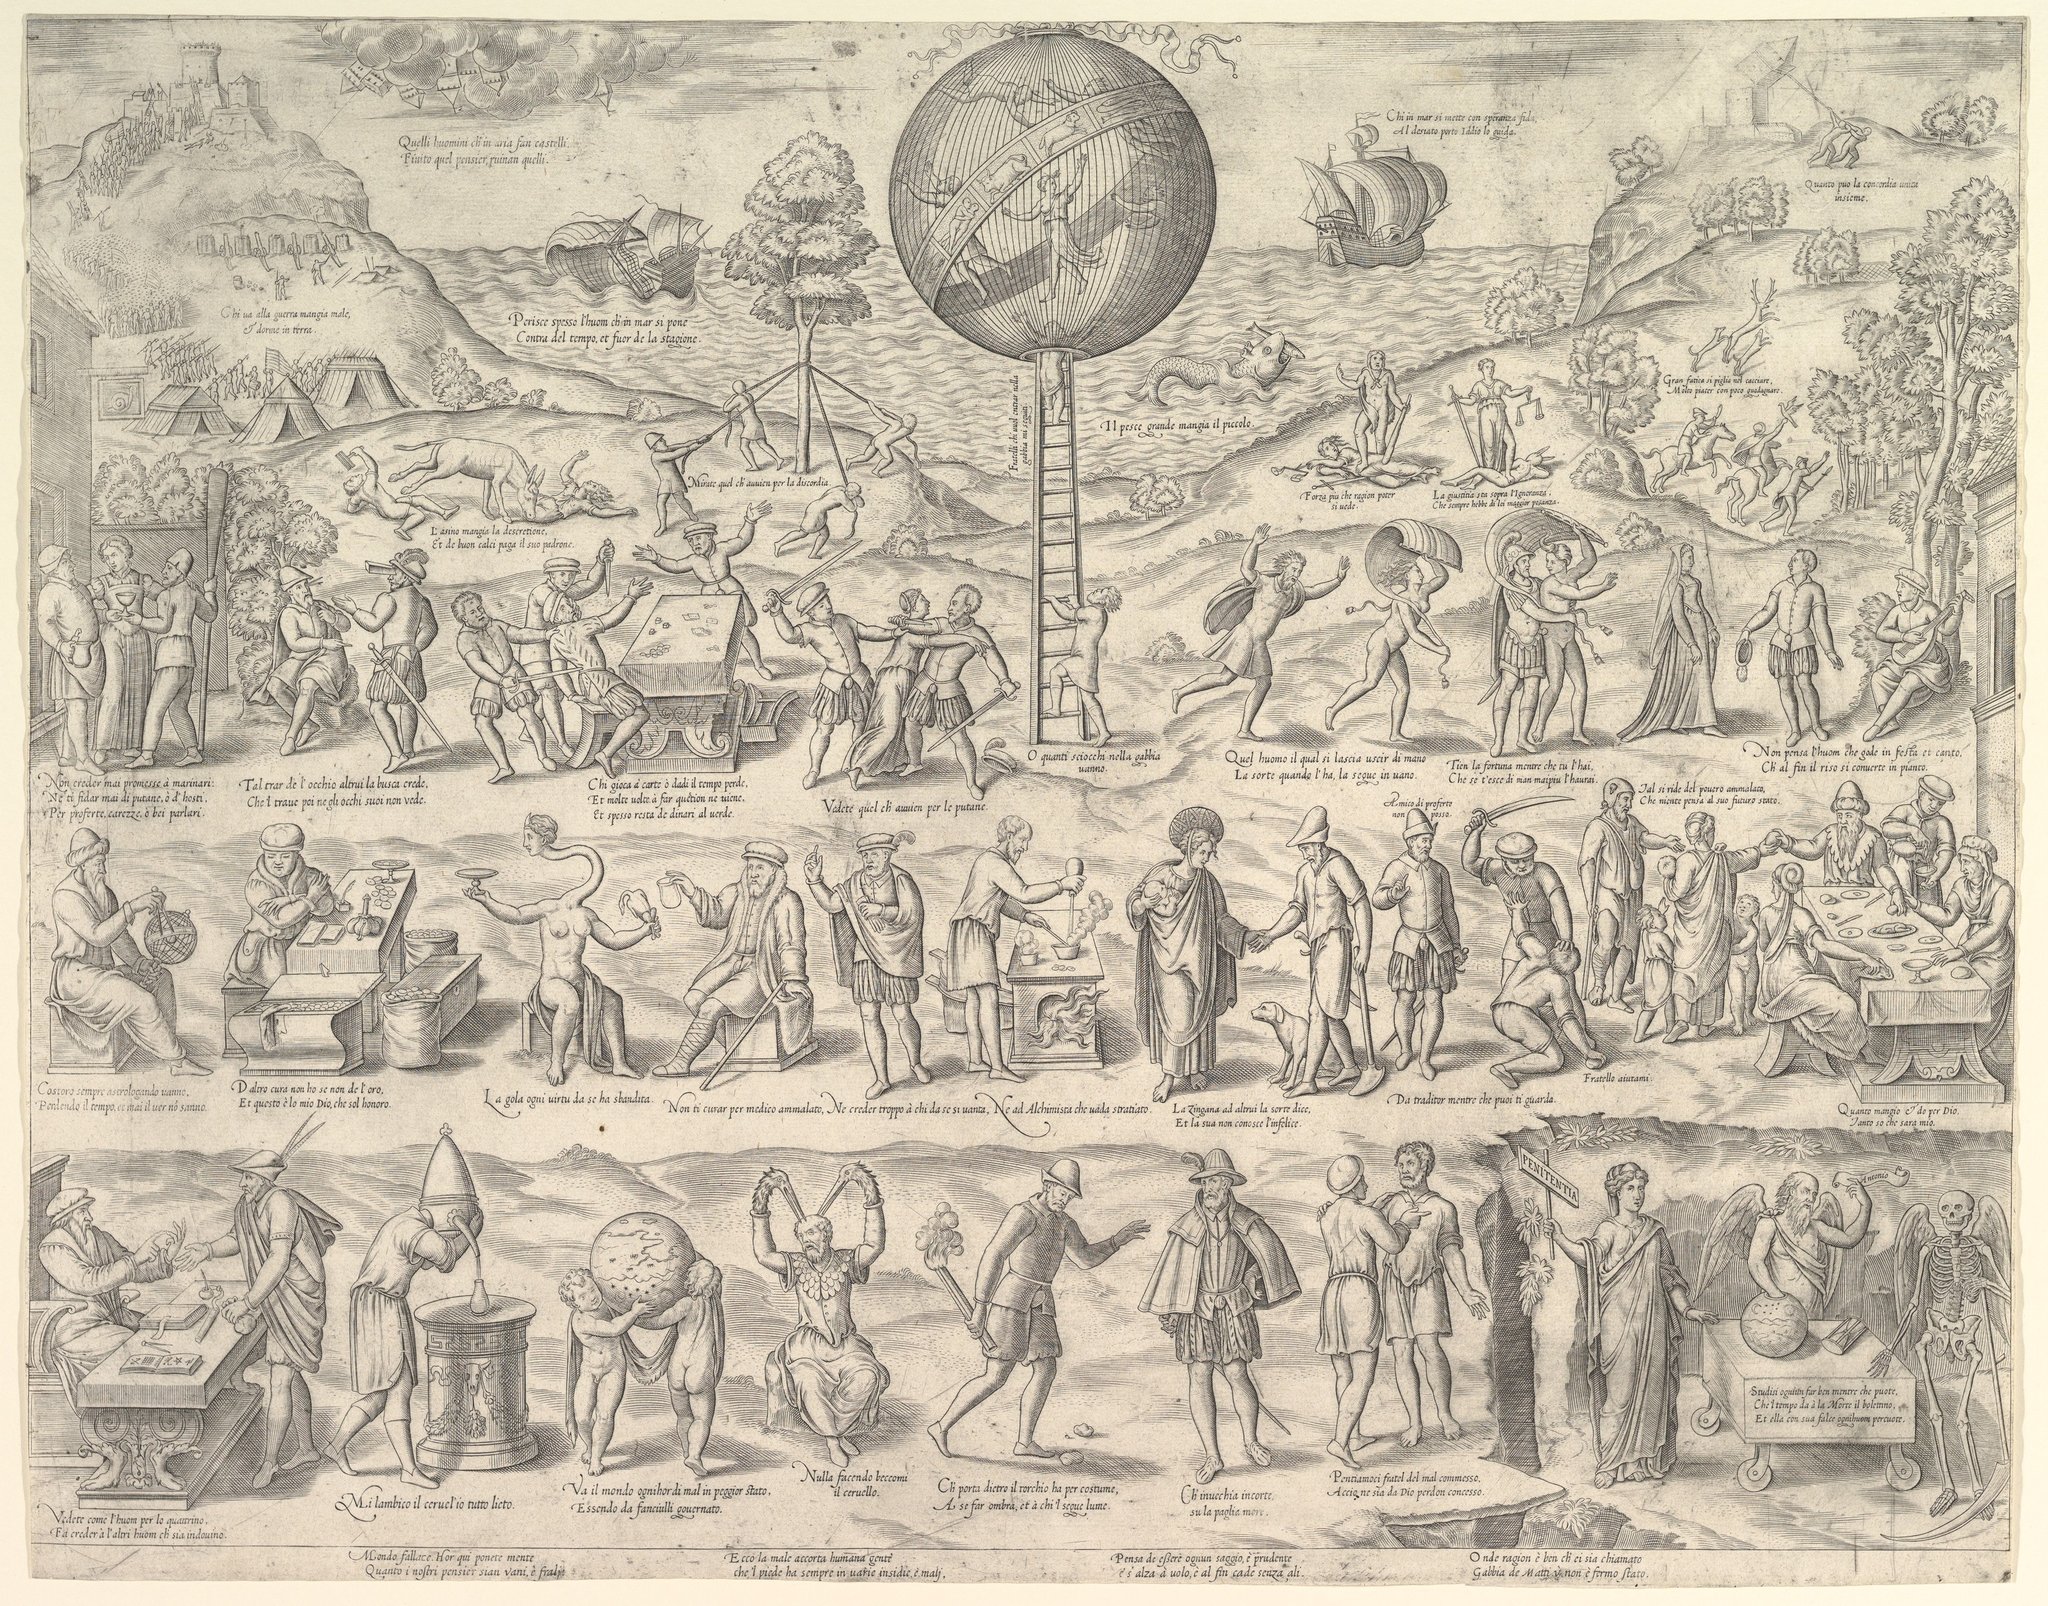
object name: print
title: The World, Cage of Fools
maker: anonymous, italian, 16th century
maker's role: artist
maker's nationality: italian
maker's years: 1500-1600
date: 1501-1600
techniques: engraving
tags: human figures,ladders